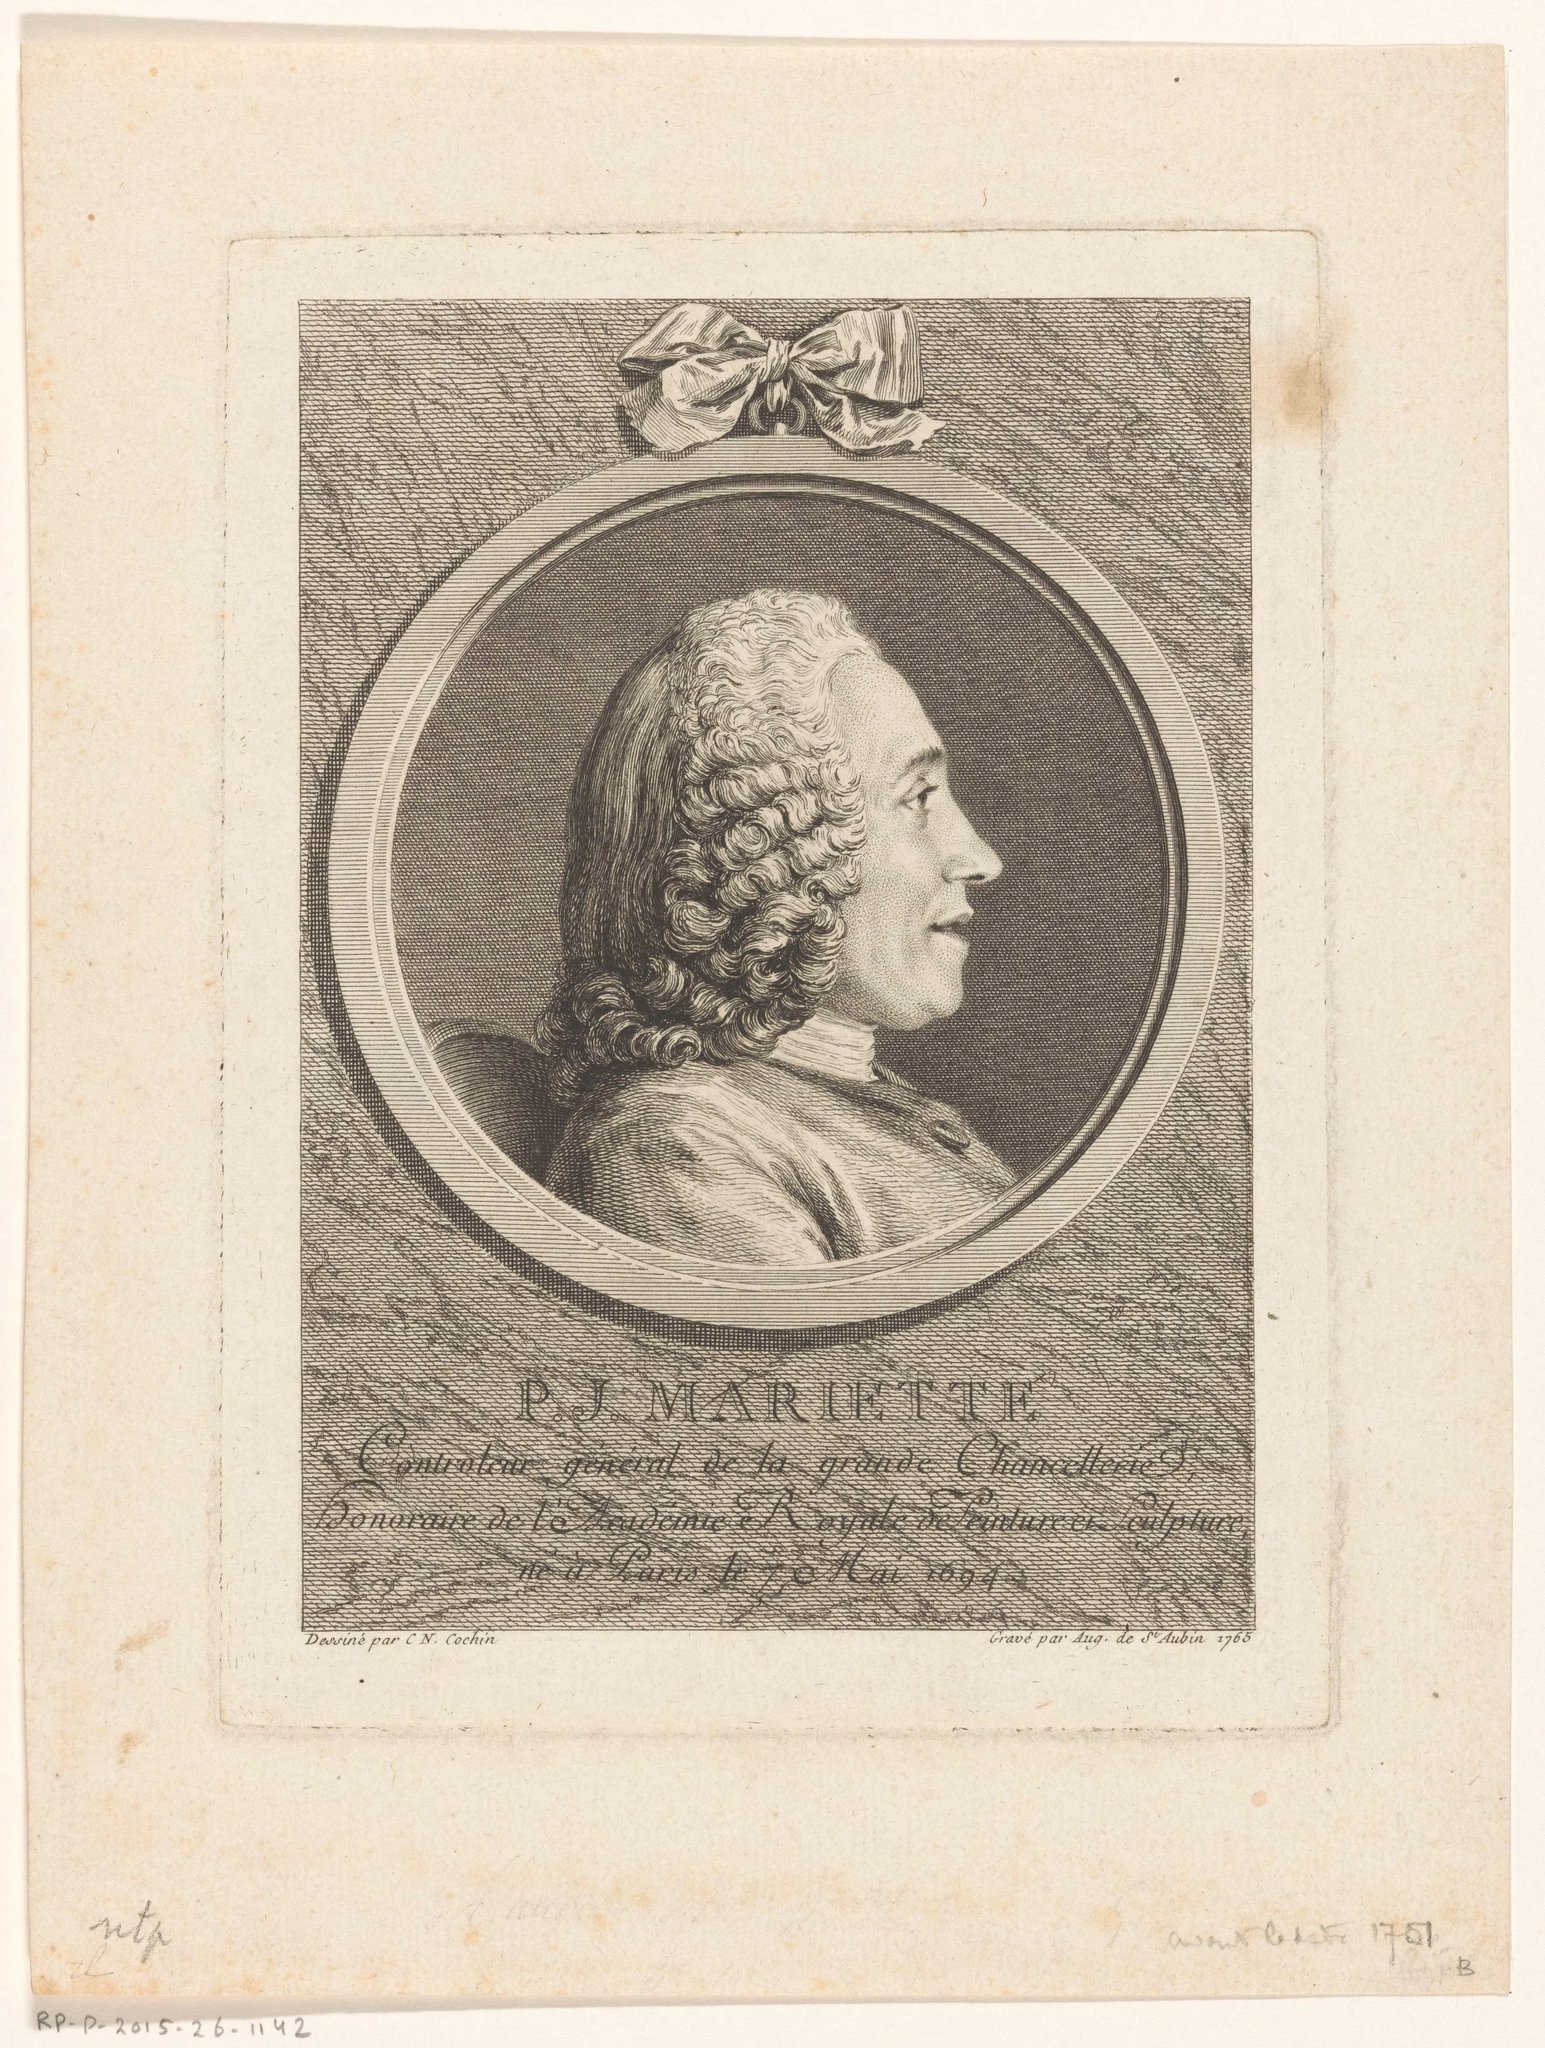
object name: print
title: Portret van Pierre Jean Mariette, prentverzamelaar en -handelaar te Parijs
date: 1765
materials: paper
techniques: etching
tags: paris, print maker, pierre jean mariette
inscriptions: collector's mark: Lugt 2228, collector's mark: Lugt 4779